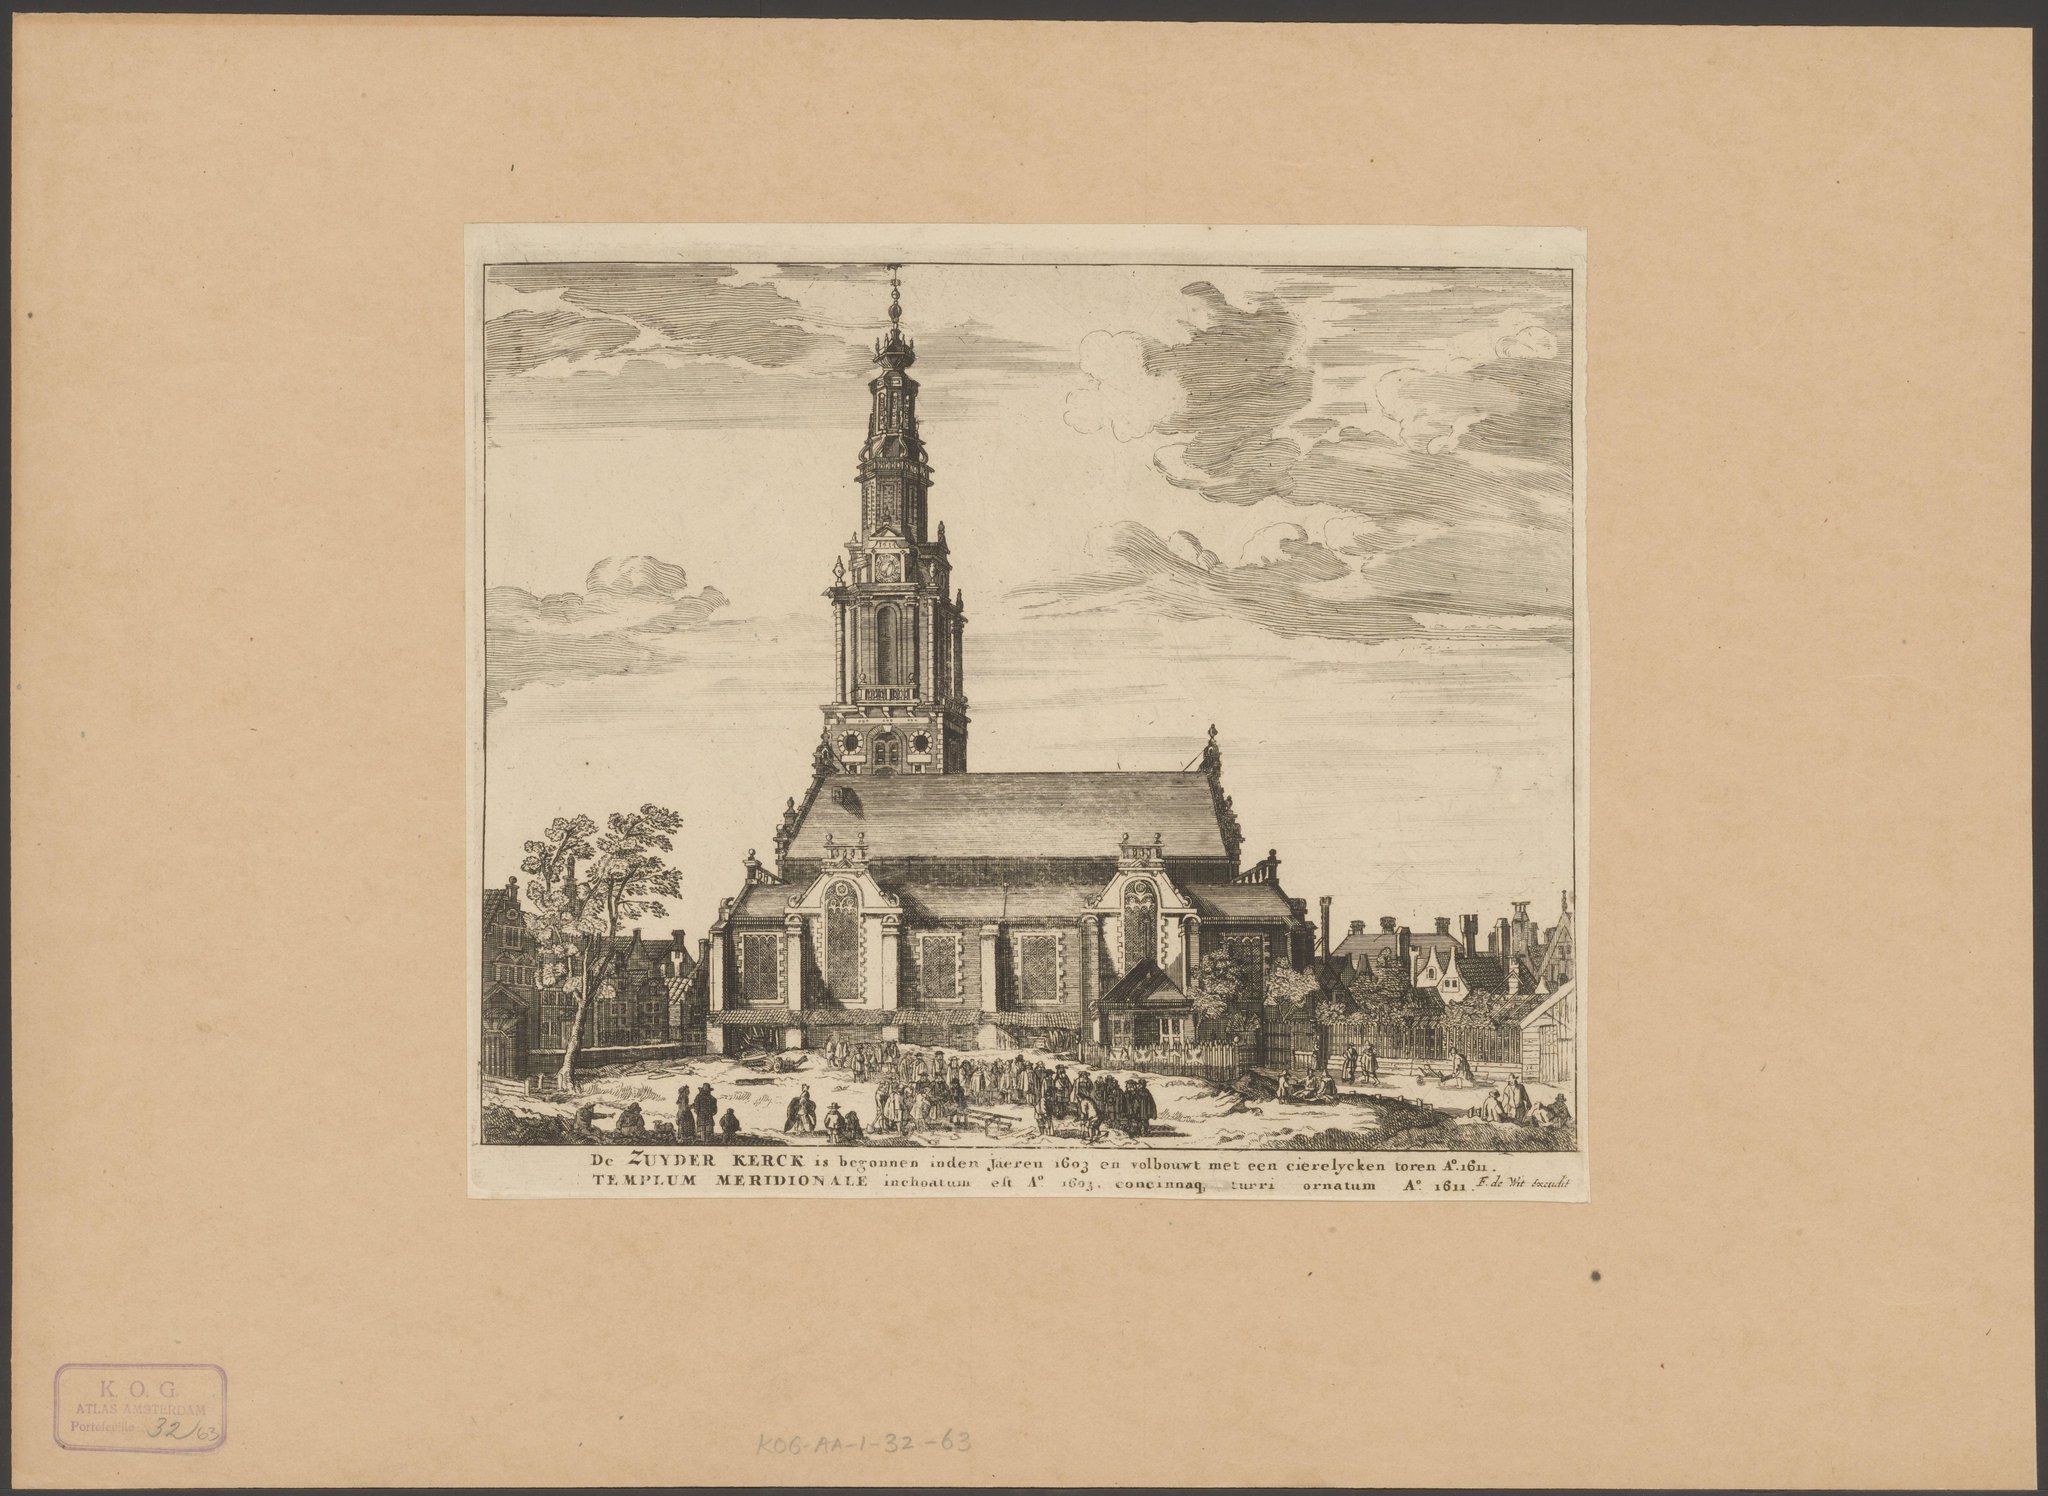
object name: print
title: Gezicht op de Zuiderkerk te Amsterdam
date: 1662-1706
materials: paper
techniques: engraving, etching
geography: amsterdam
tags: church (exterior), funerary ceremonial, churchyard, cemetery, grave digger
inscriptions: collector's mark: Lugt 1641b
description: Onderwerpsrubriek binnen de Atlas Amsterdam: Kerkwezen: Hervormde Gemeente: Zuiderkerk.